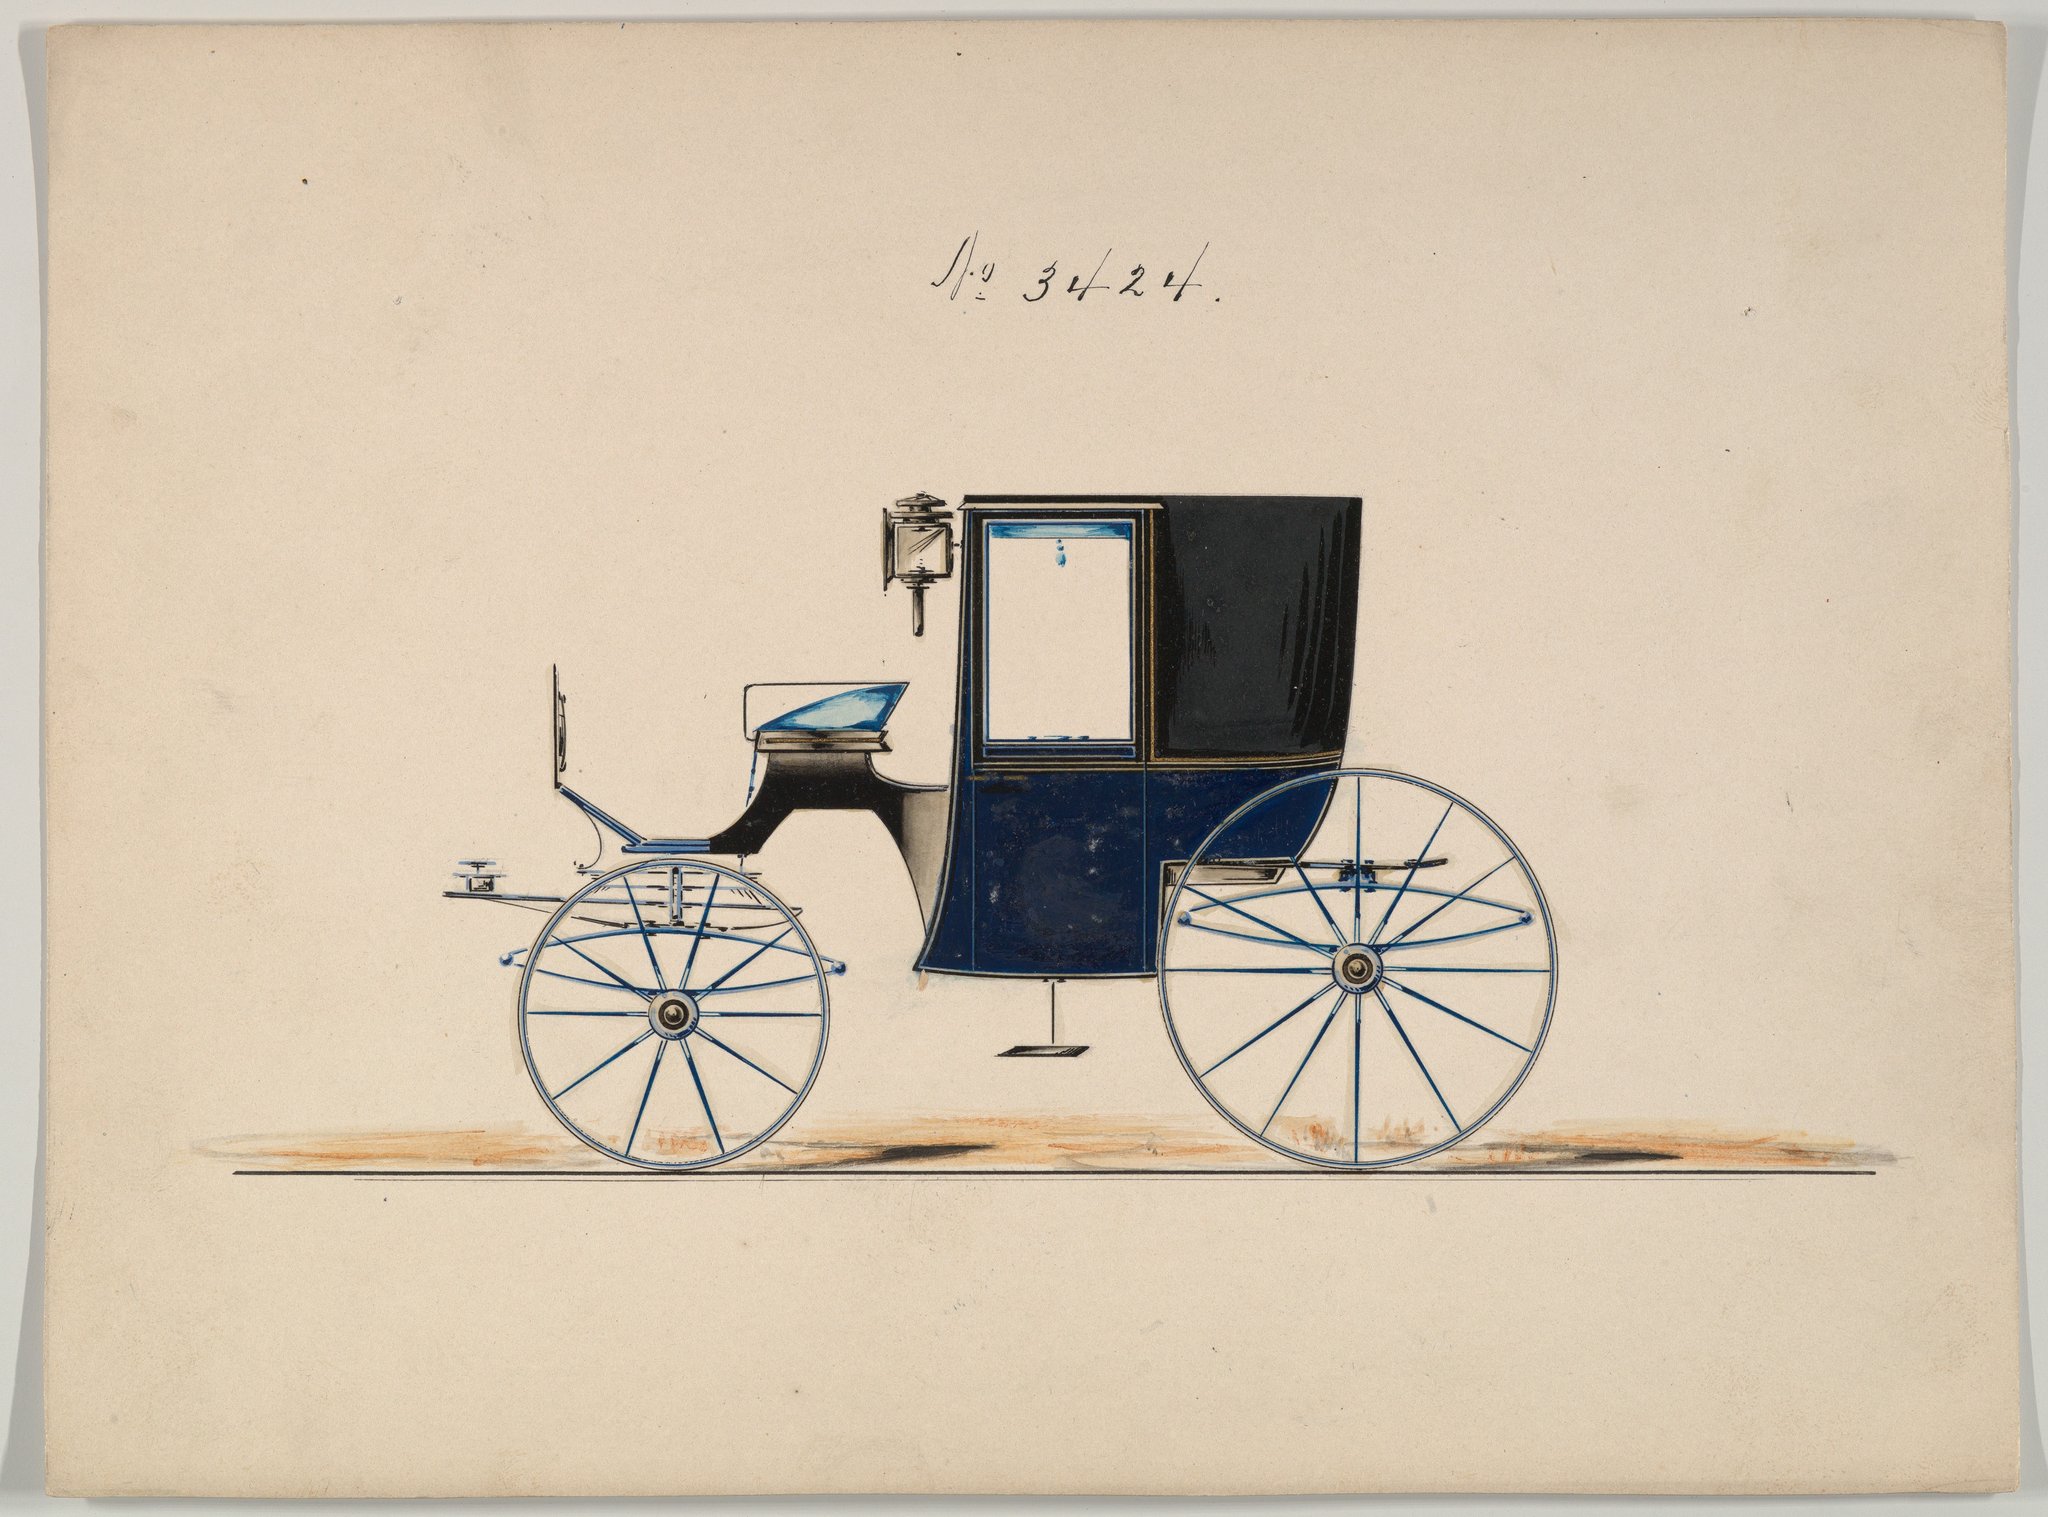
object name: drawing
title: Brougham #3424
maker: brewster & co.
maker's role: manufacturer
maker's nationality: american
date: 1878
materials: gouache, gum arabic, ink, watercolor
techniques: pen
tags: carriages